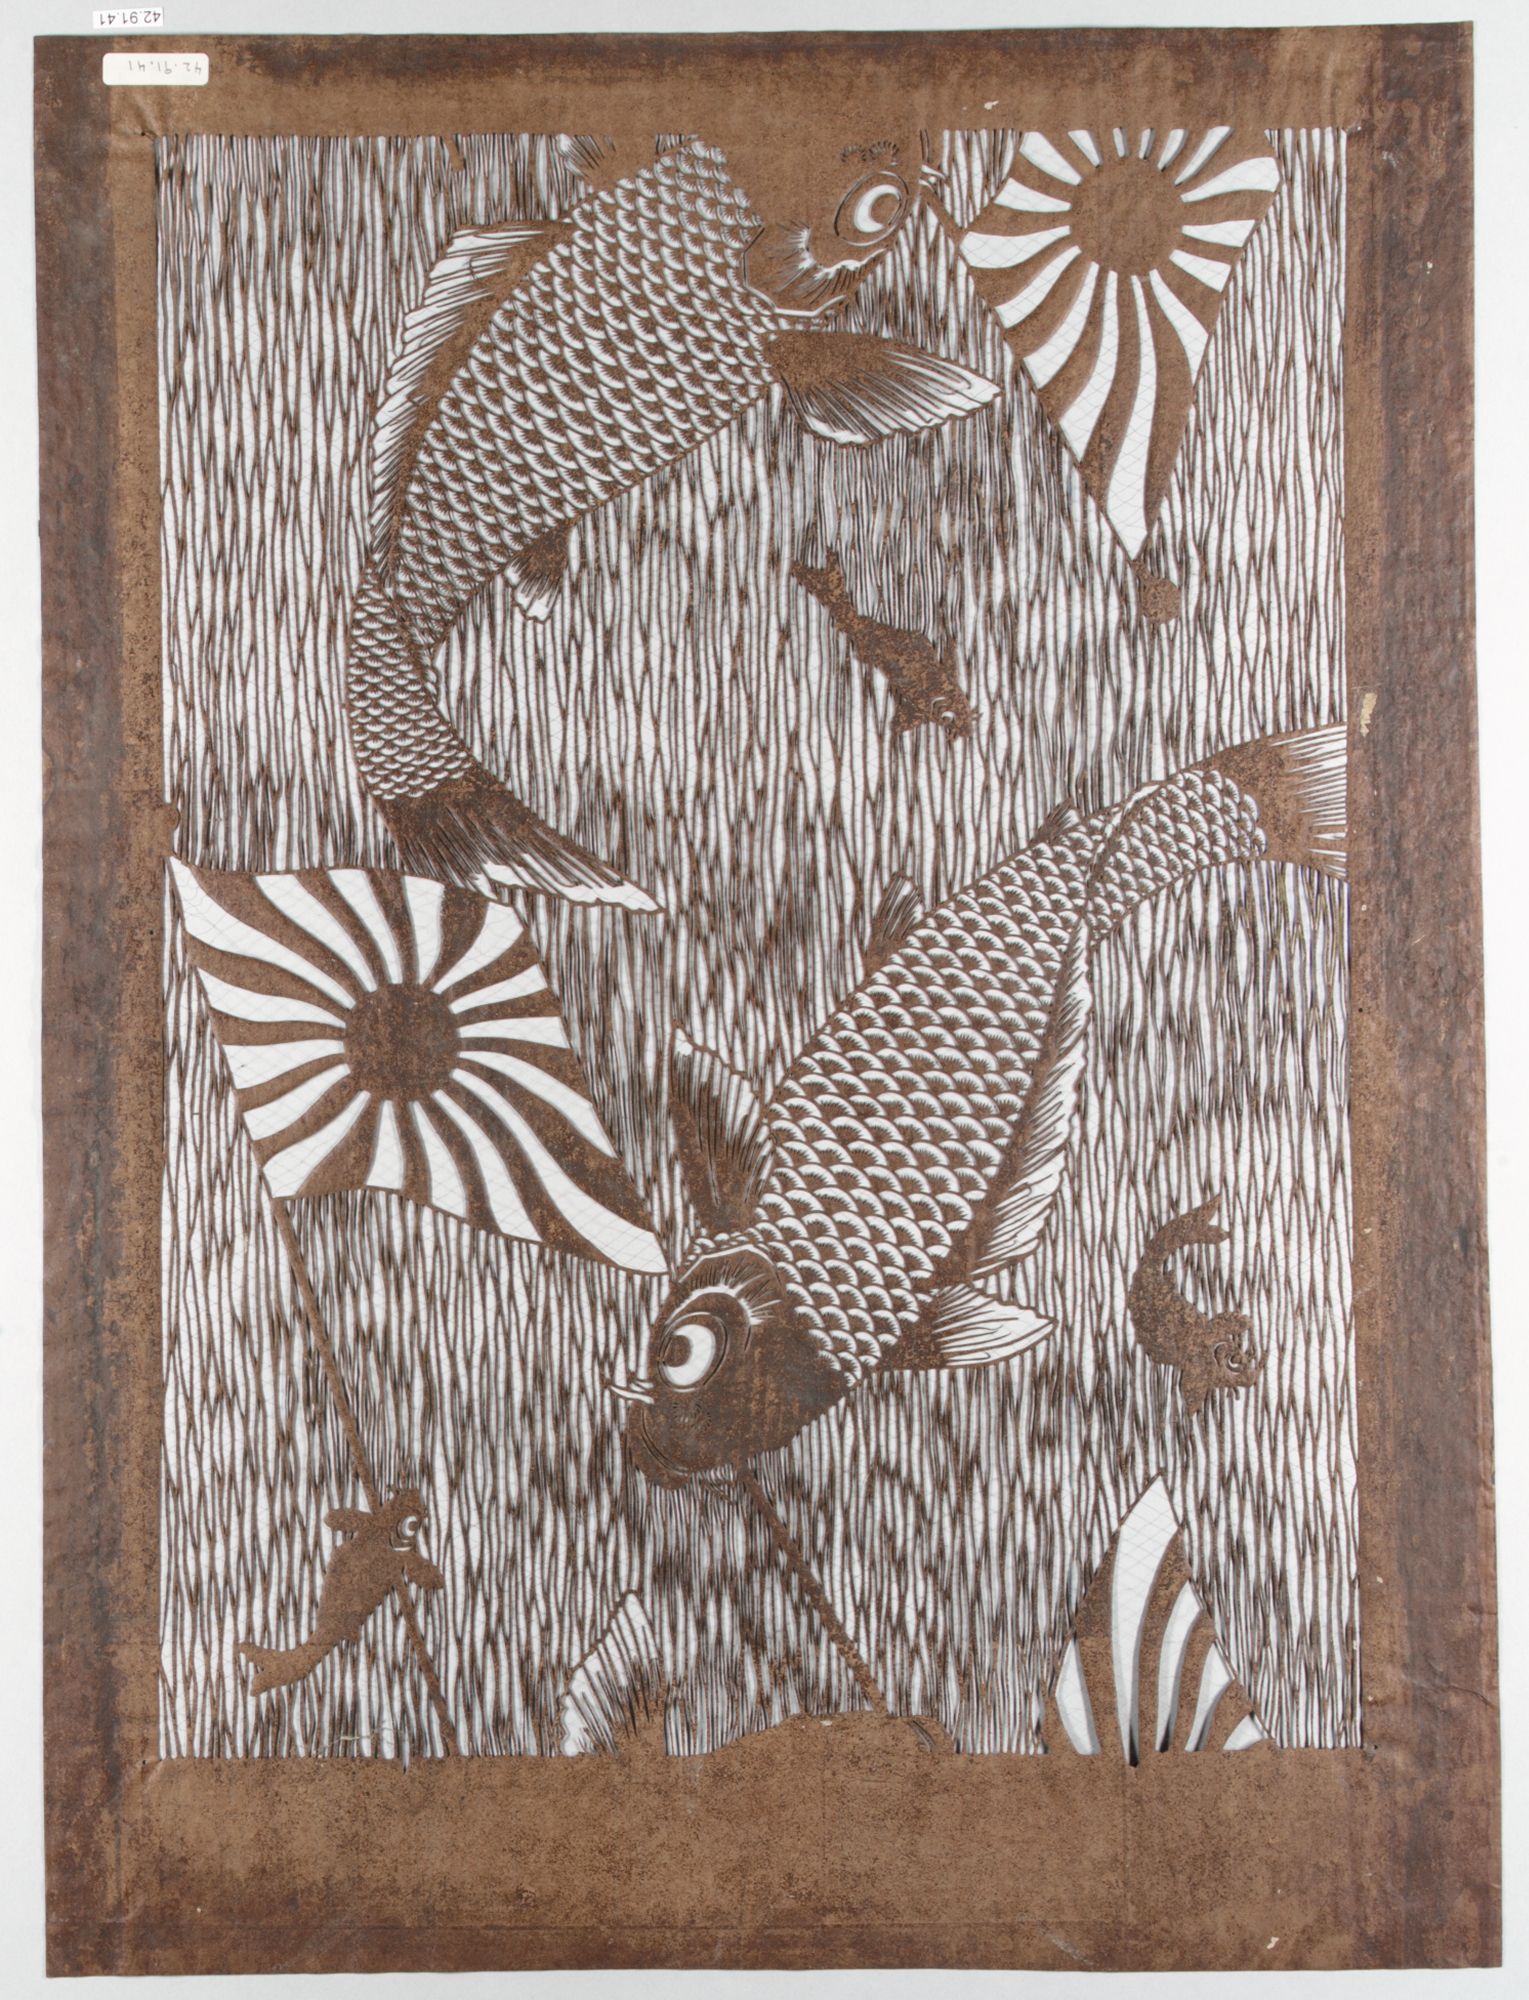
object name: stencil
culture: japanese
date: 1801-1900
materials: paper, silk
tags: fish,flags